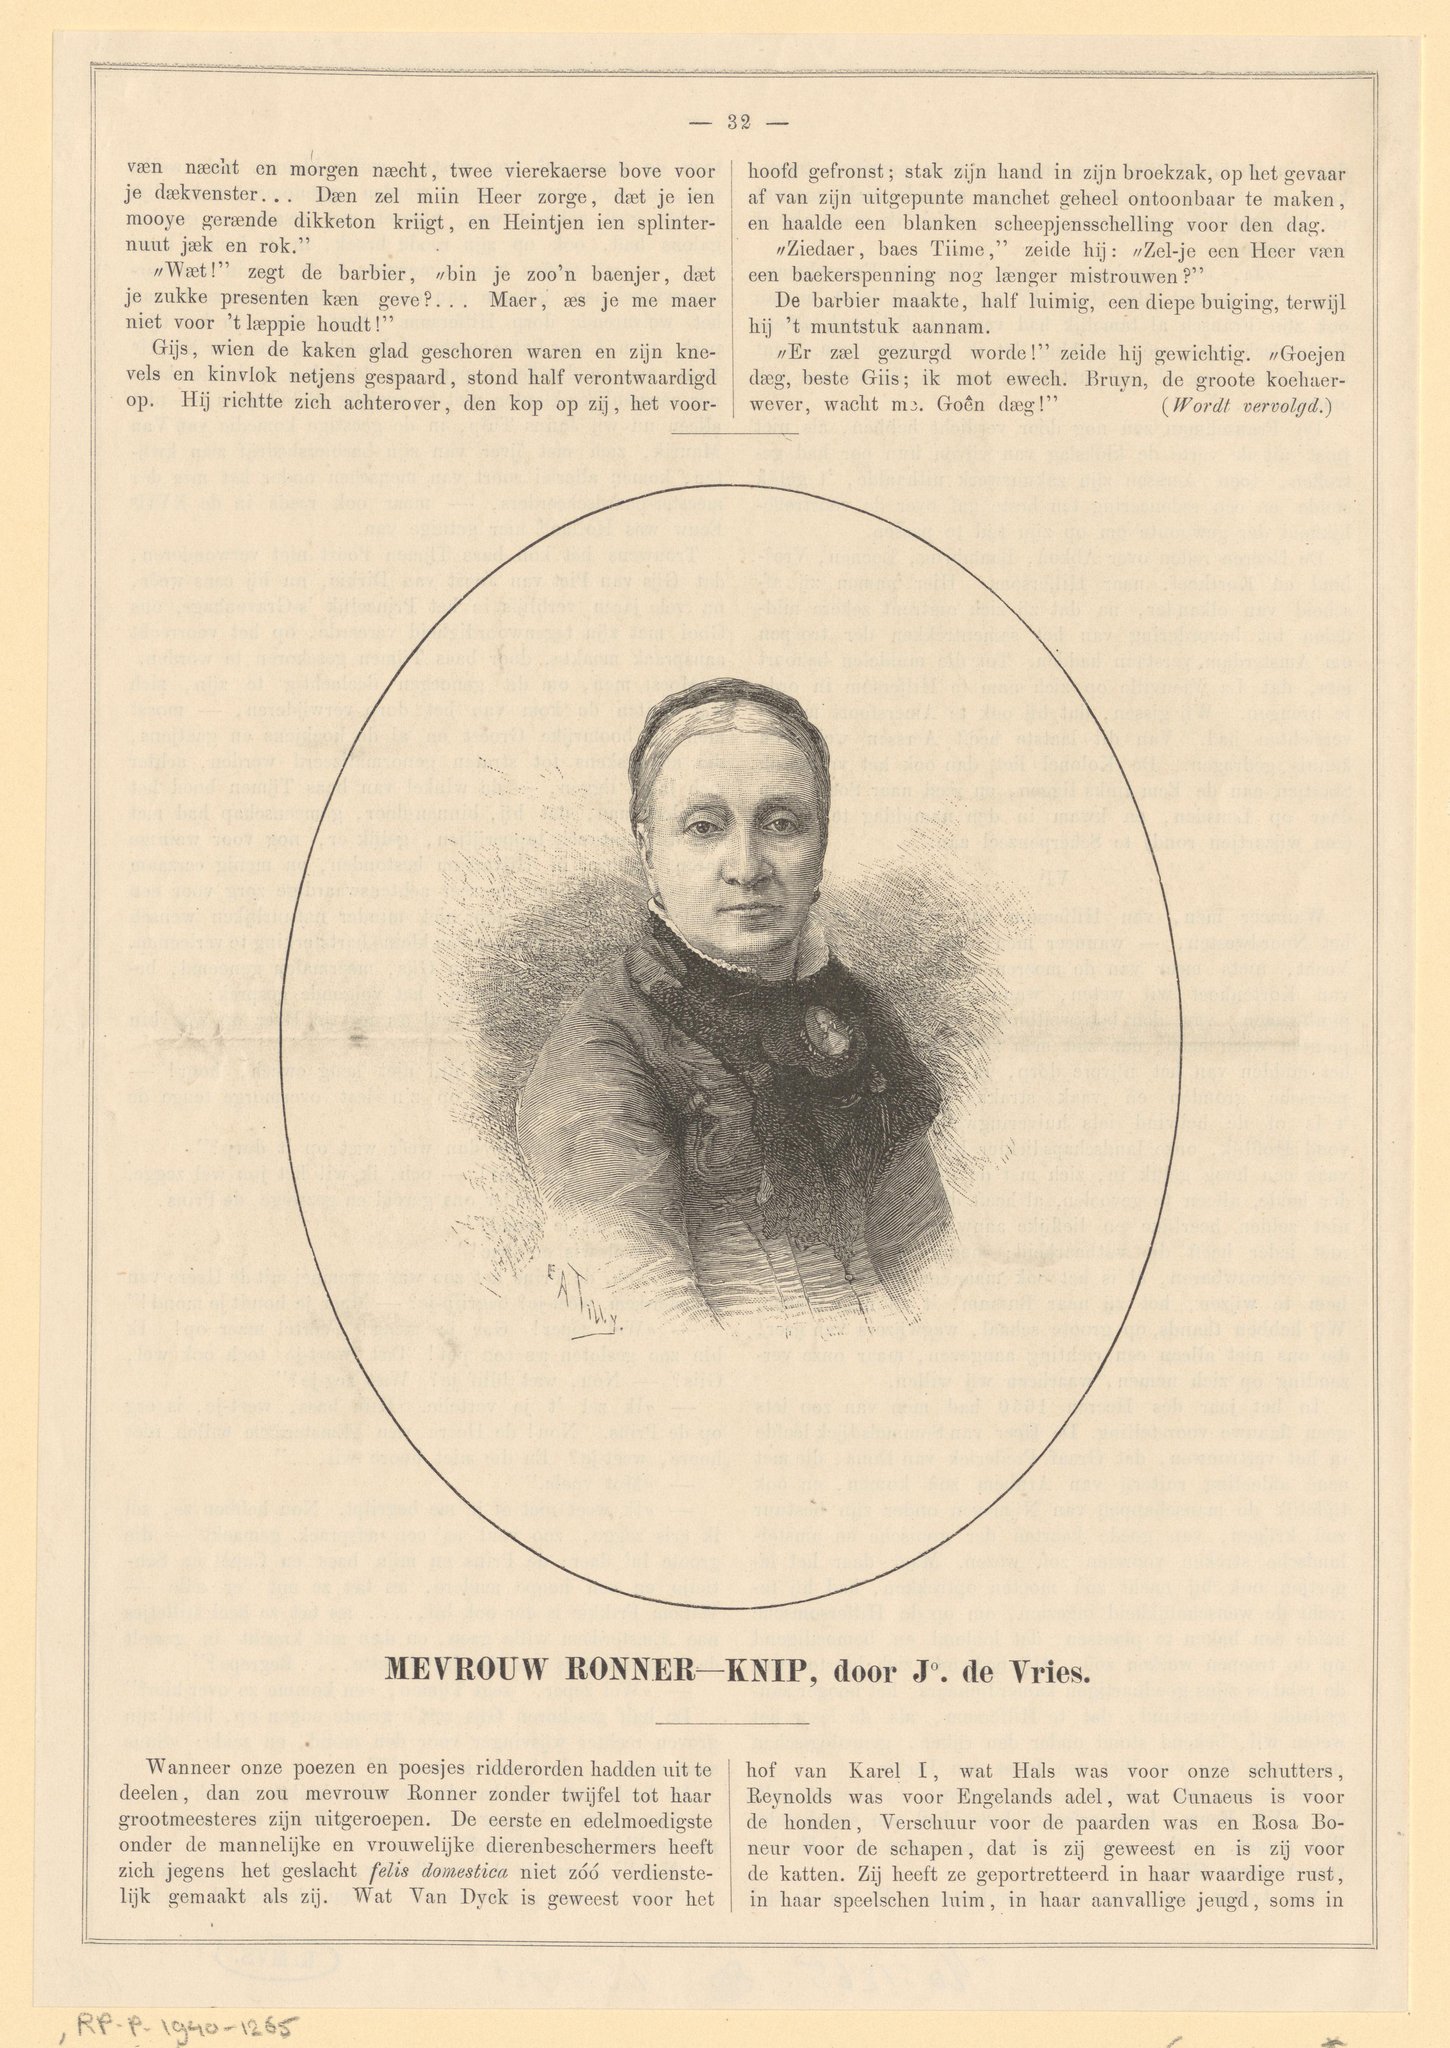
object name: print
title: Portret van Henriëtte Ronner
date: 1886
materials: paper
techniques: letterpress printing, engraving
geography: haarlem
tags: amsterdam, painter, draughtsman, henriëtte ronner, historical persons - bb - woman, portrait, self-portrait of painter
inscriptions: collector's mark: Lugt 2760, collector's mark: Lugt 2228